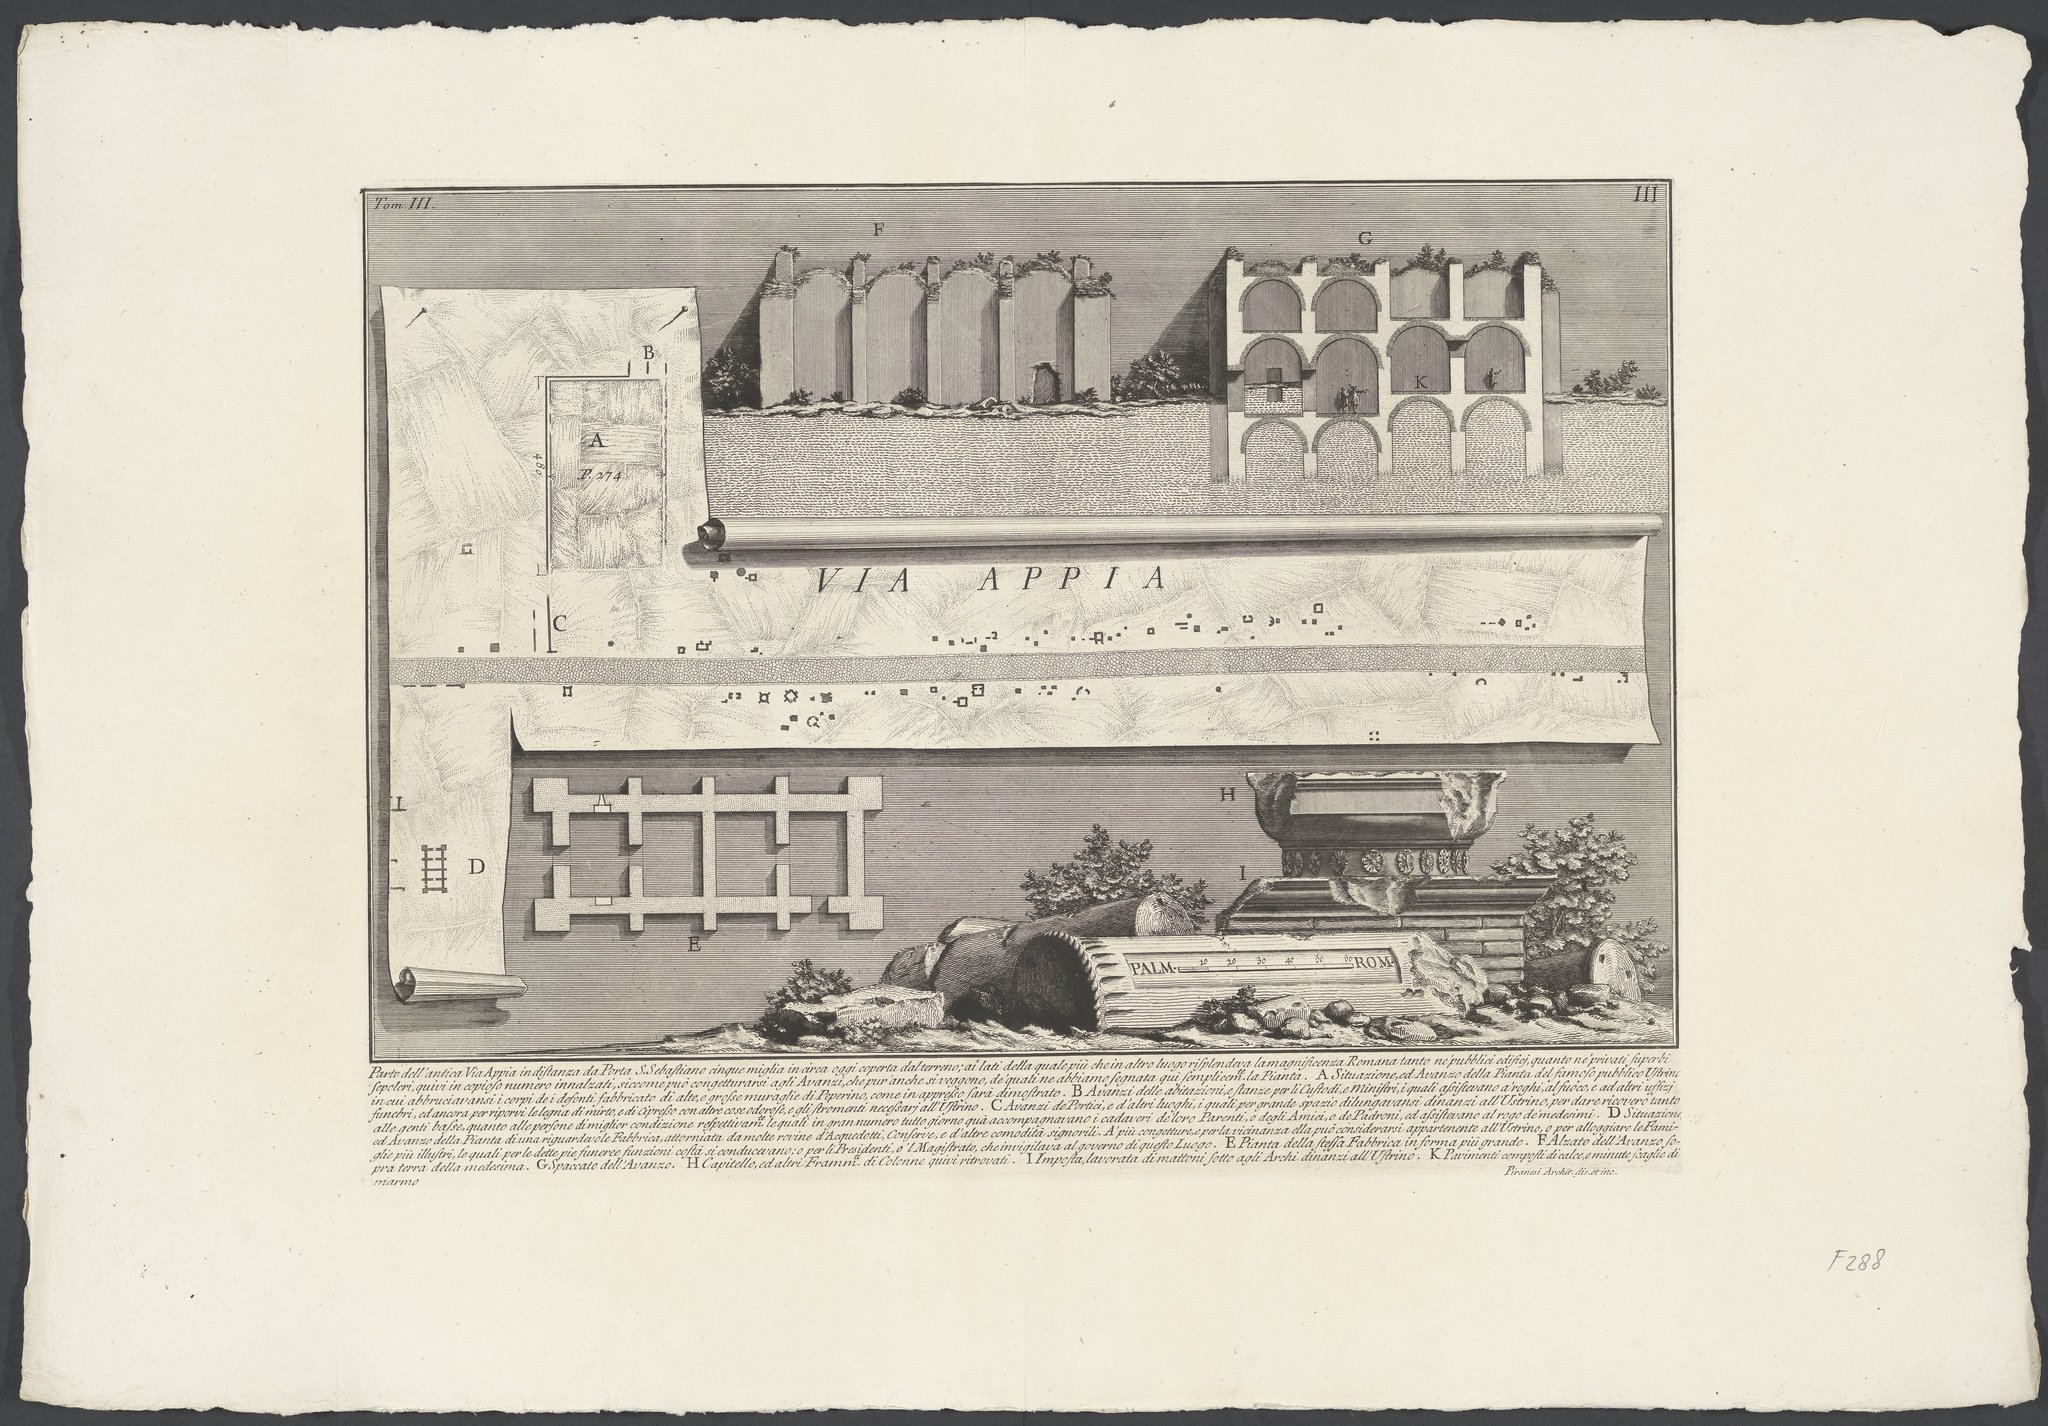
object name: print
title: Le Antichità Romane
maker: giovanni battista piranesi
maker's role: designer, draughtsman, print maker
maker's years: 1720-1778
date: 1756-1757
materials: paper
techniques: etching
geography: rome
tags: grave, tomb, plan ~ architecture, street, public road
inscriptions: collector's mark: Lugt 2228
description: Deze prent maakt deel uit van de serie 'Le Antichità Romane'. Piranesi deed meer dan acht jaar voorstudie voor deze 250 platen tellende serie die in vier volumes werd uitgegeven. Hij produceerde de prenten tussen ca. 1756 en 1757. De serie bevat ook prenten door of naar andere prentmakers, onder wie Francesco Bianchini en Girolamo Rossi.